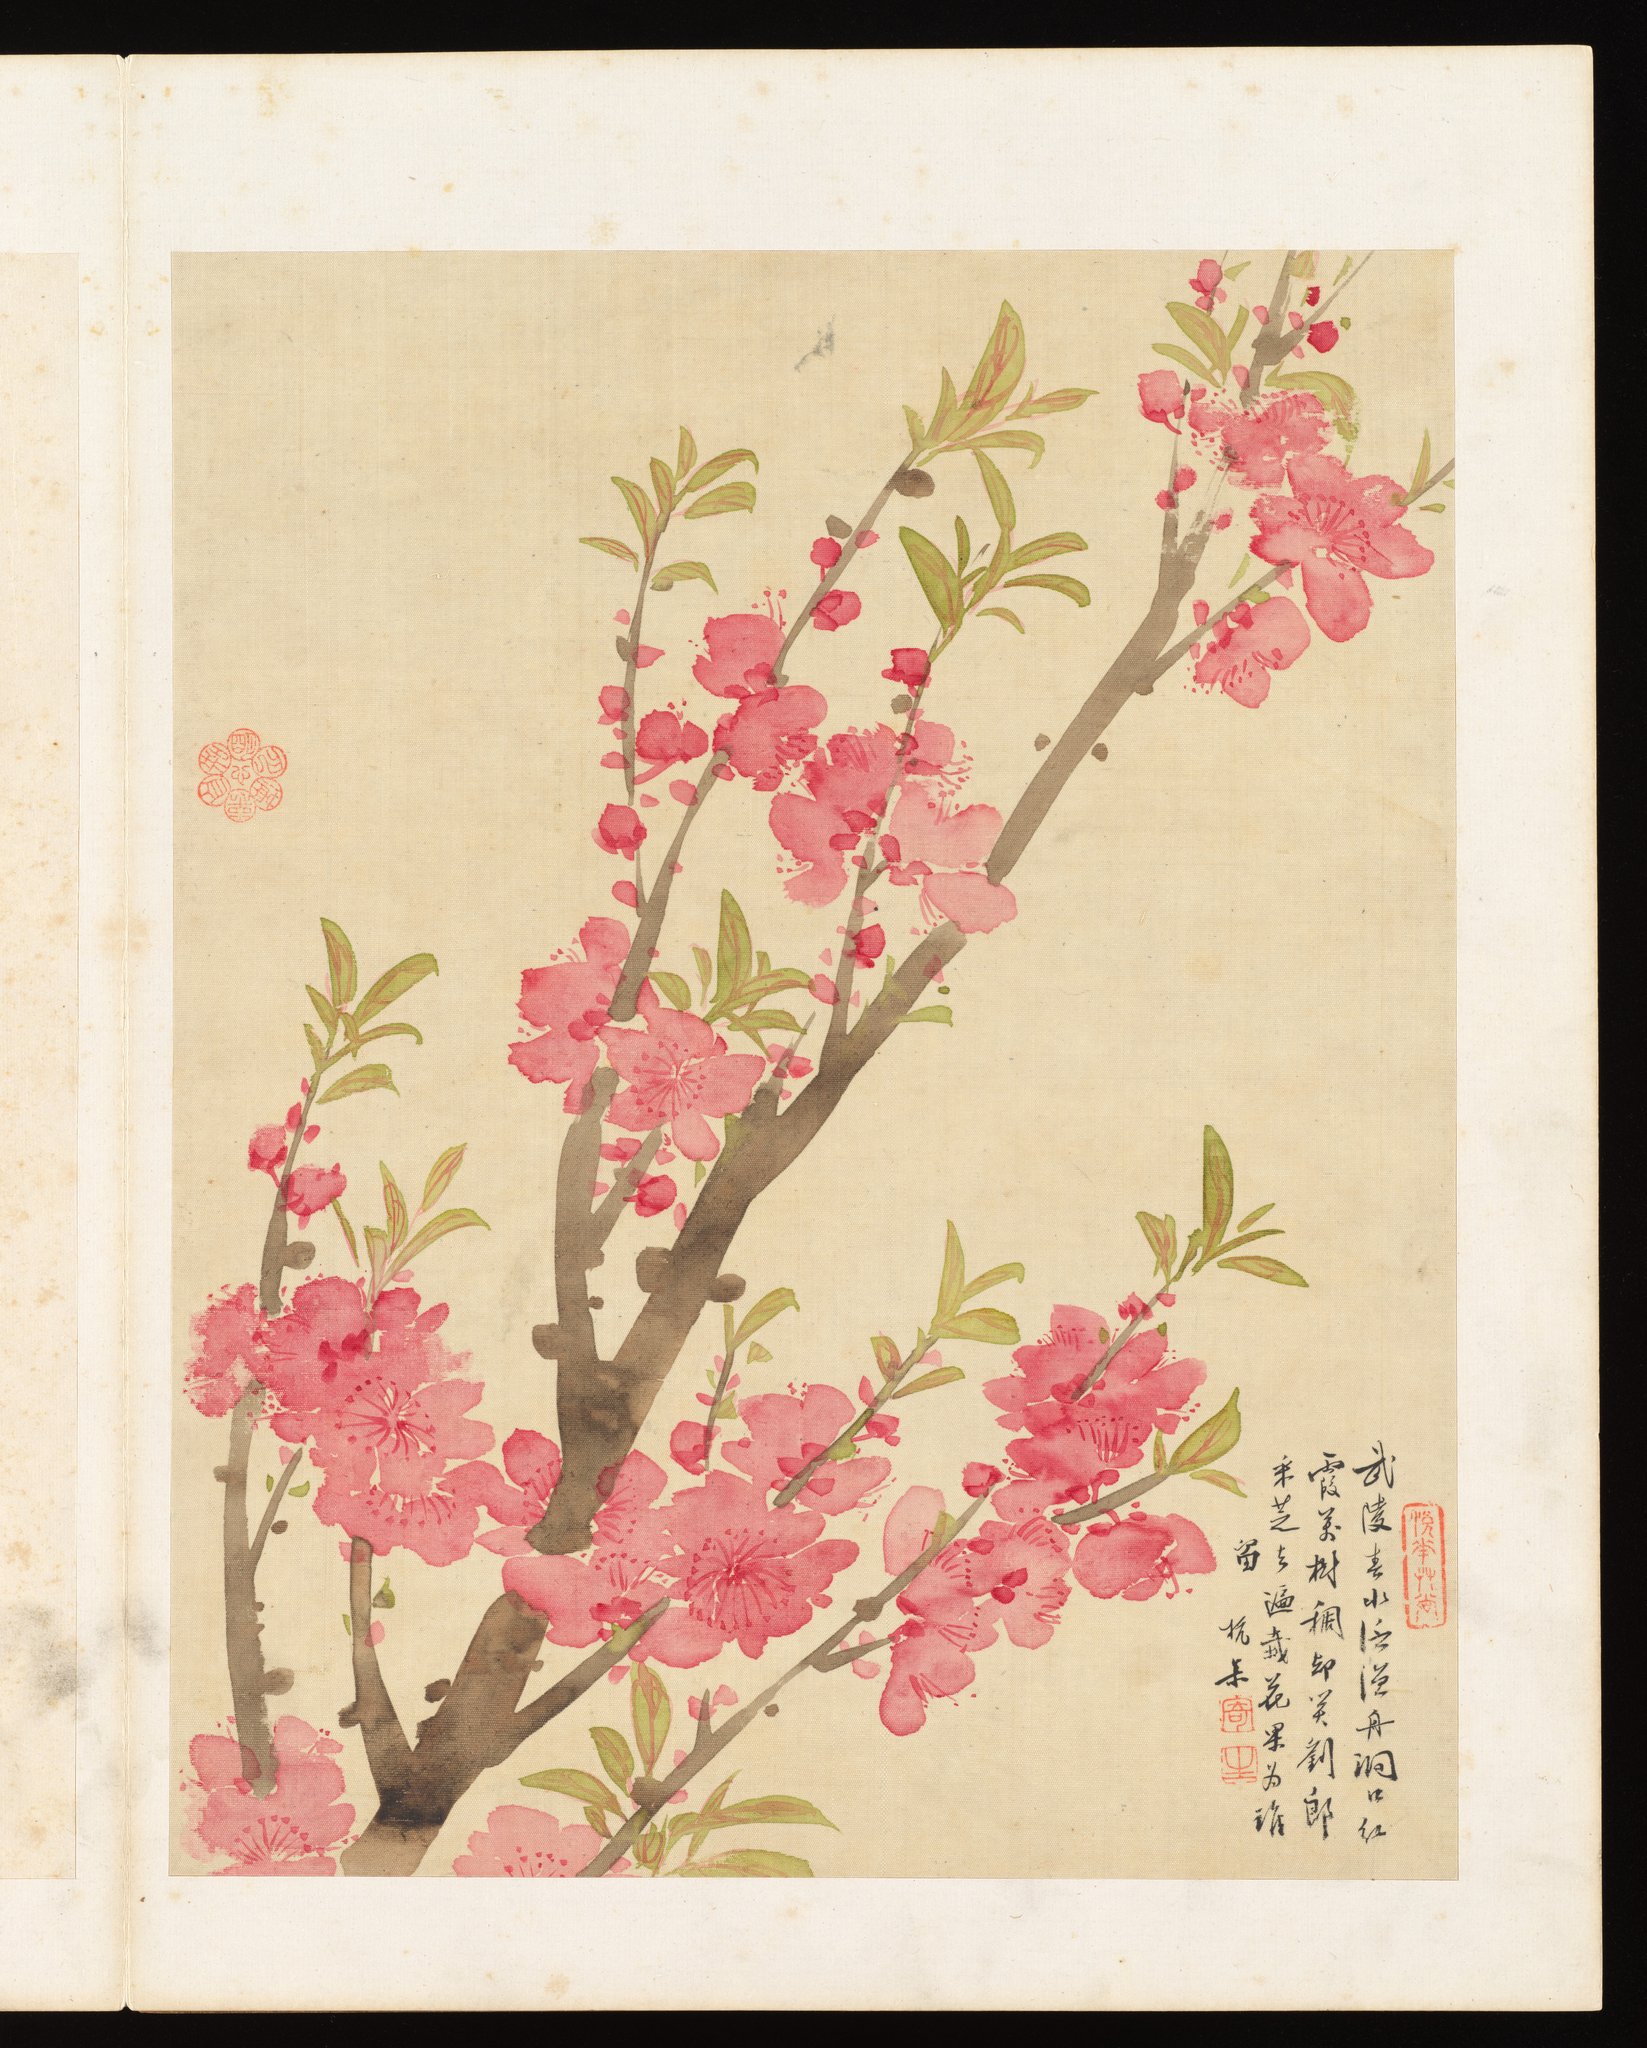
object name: album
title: Flowers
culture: chinese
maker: liang yuwei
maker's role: artist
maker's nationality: chinese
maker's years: 1844-1917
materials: ink, silk